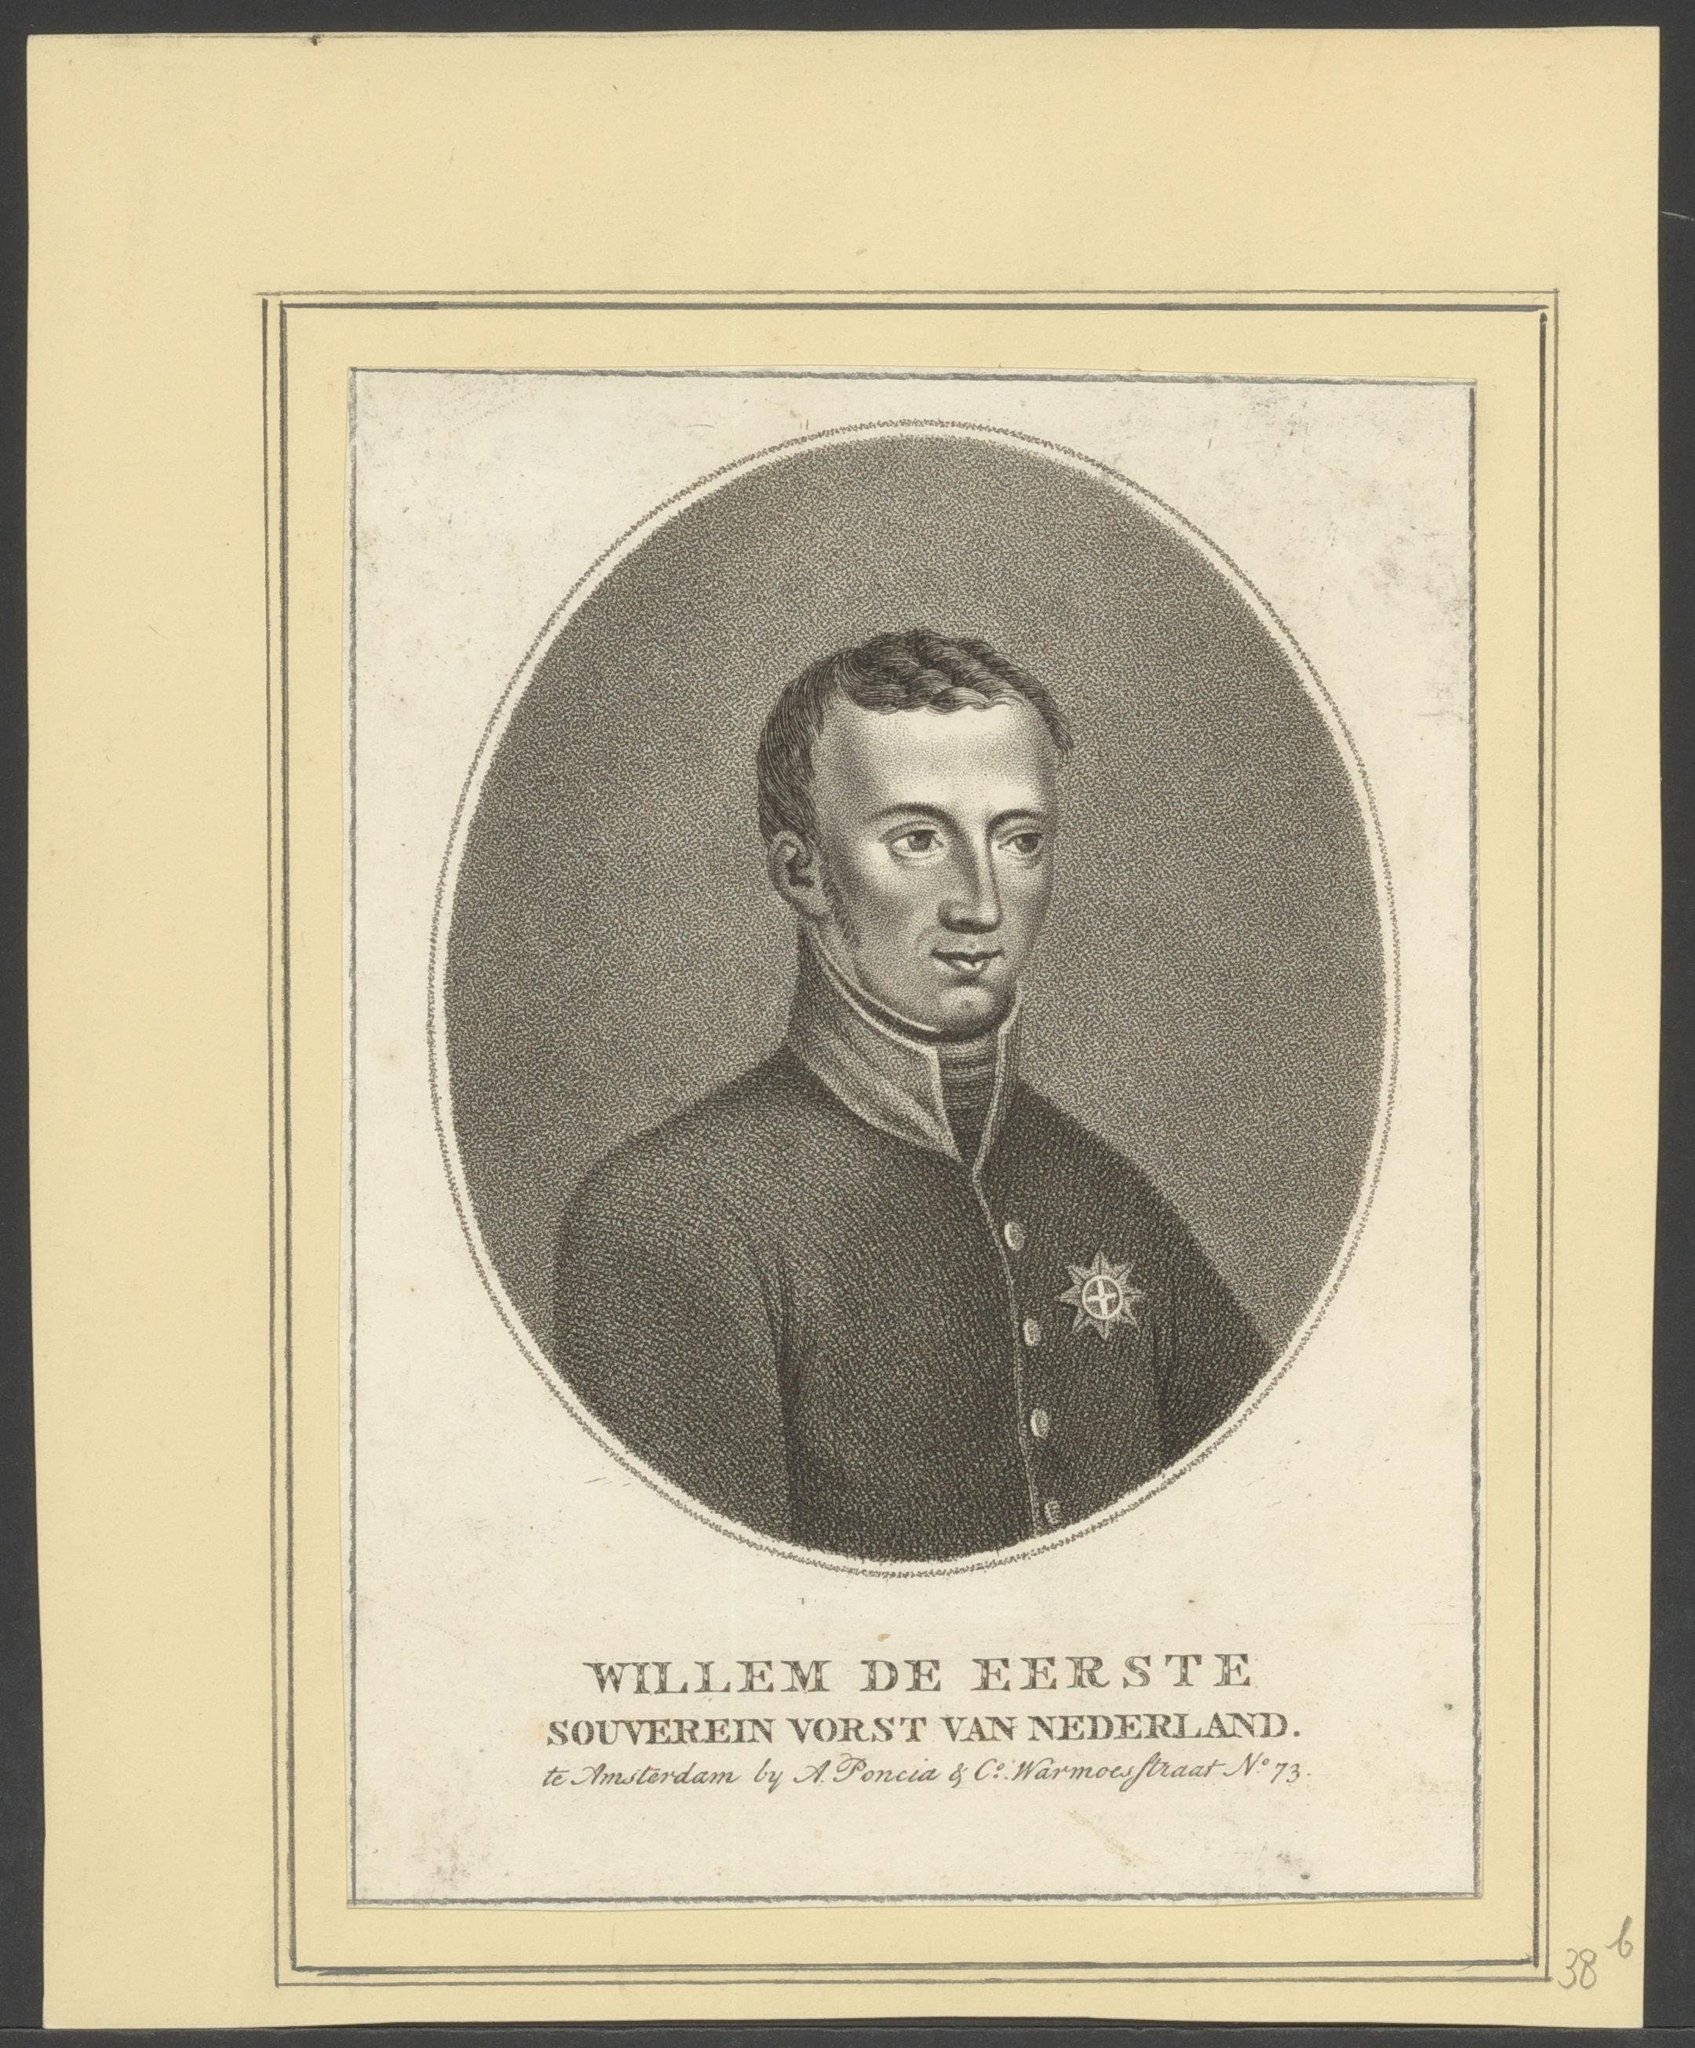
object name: print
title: Willem de Eerste souverein vorst van Nederland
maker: Anonymous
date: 1800-1849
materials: paper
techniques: etching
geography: amsterdam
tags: the hague, berlin, william i of the netherlands, historical persons, king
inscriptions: collector's mark: Lugt 1641, stamp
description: Onderwerpsrubrieken binnen de Atlas Zeden en Gewoonten: Portretten, Portretten van Vorsten uit het huis van Oranje, Regeerende Vorsten, Koningen uit het huis van Oranje.